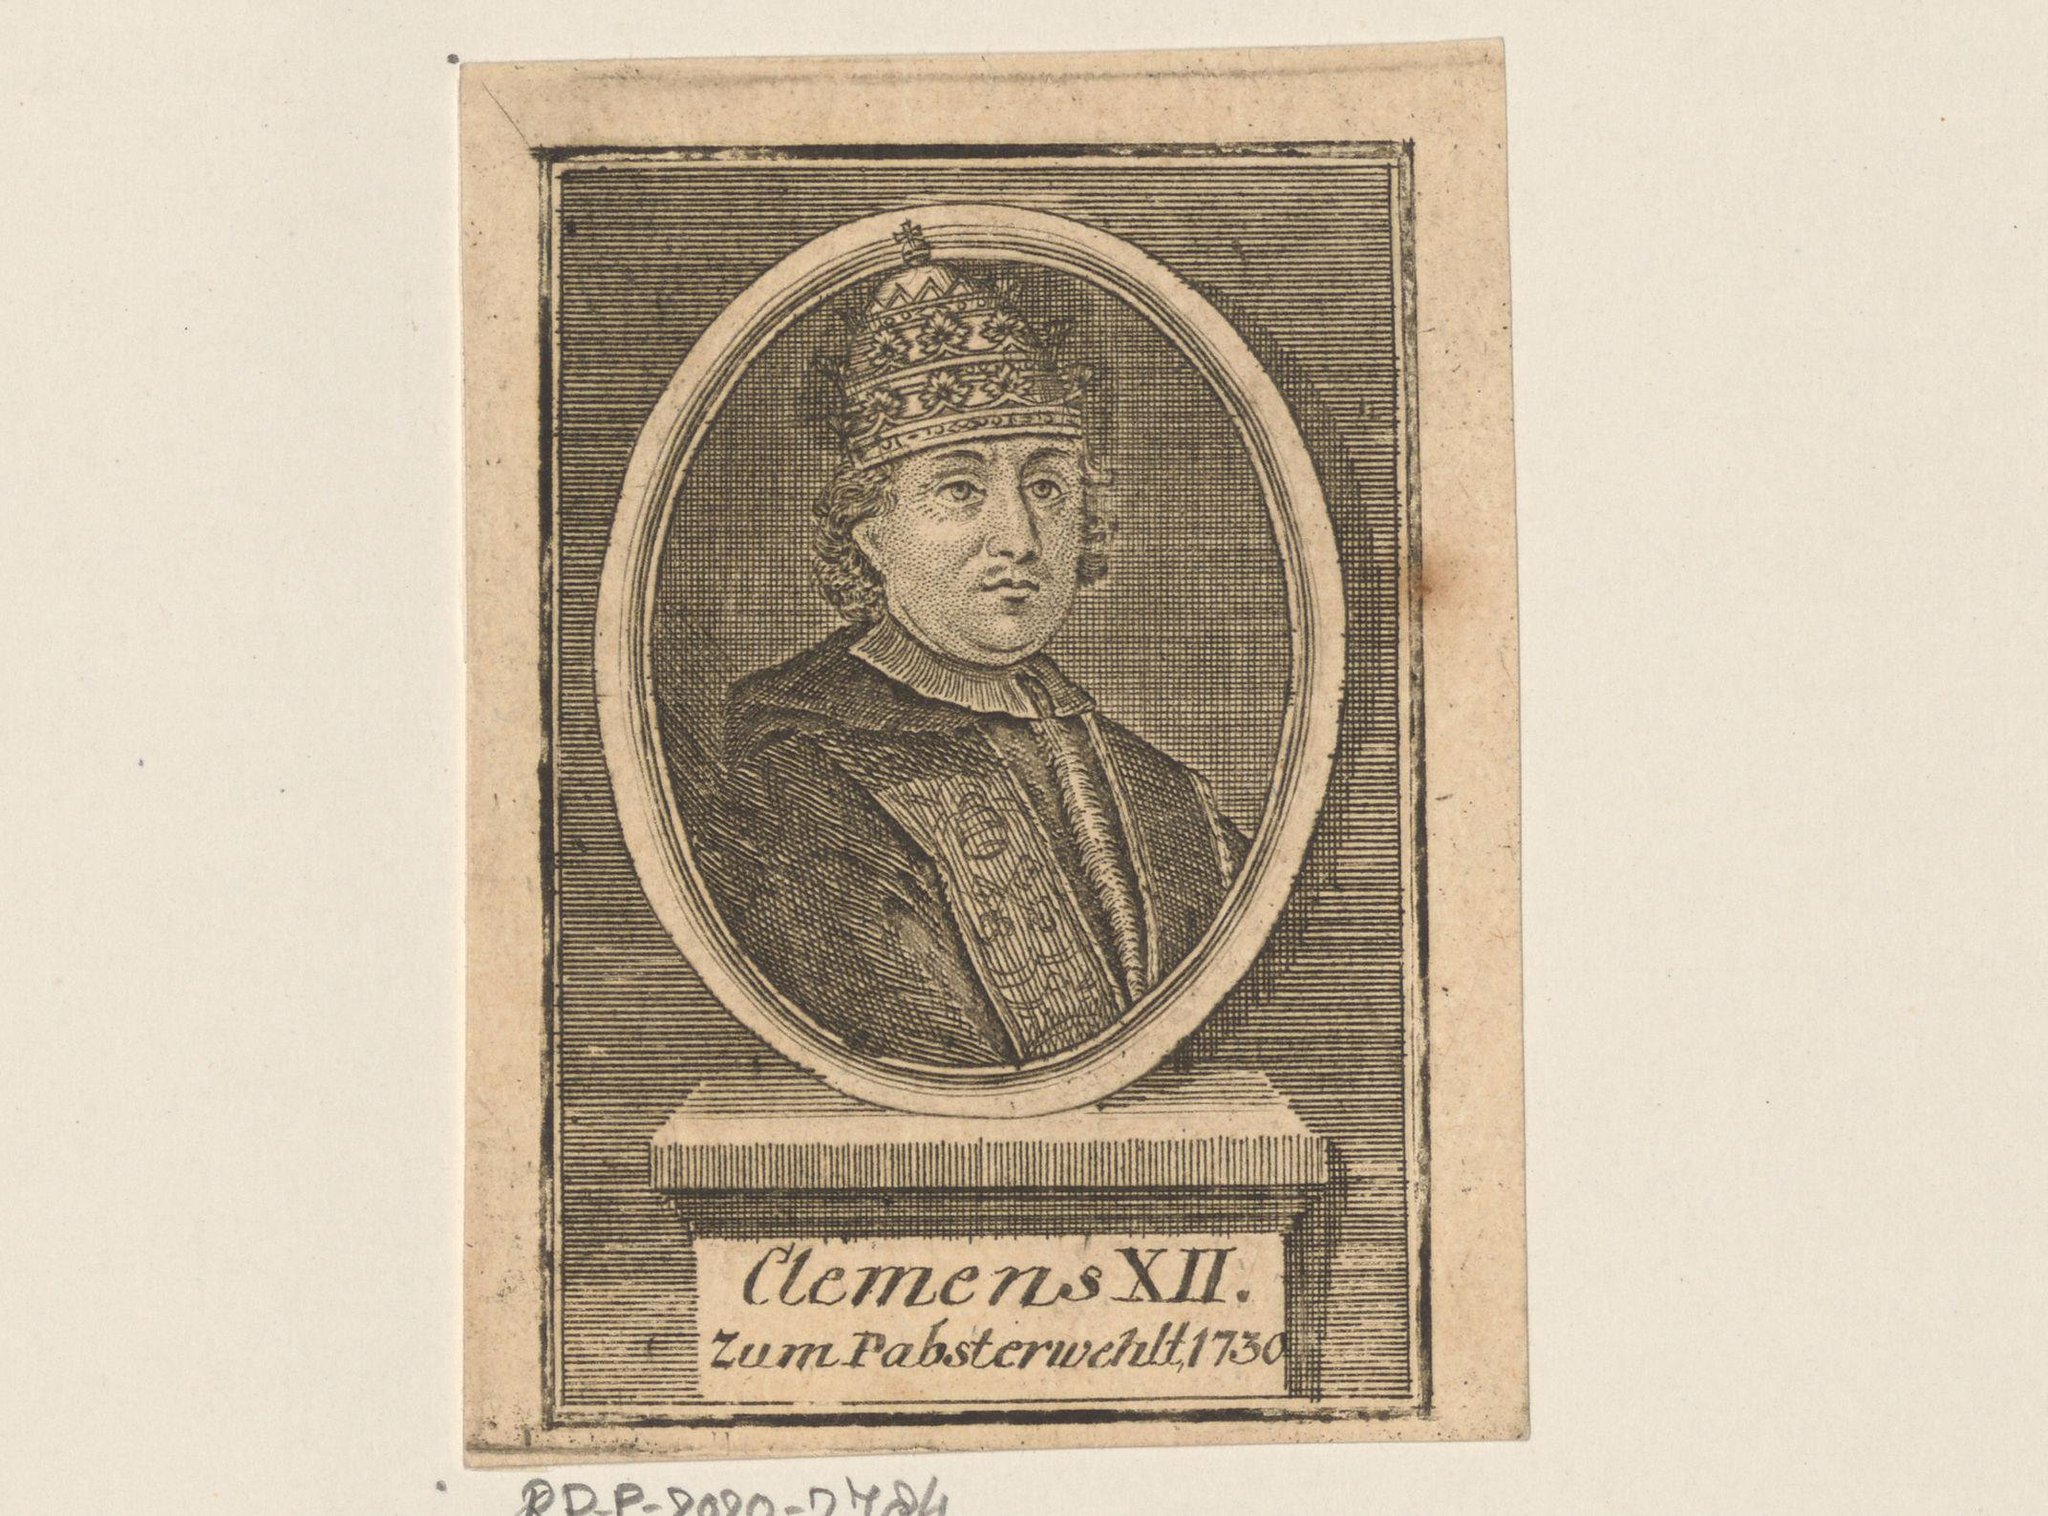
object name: print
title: Portret van paus Clemens XII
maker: Anonymous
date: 1730-1799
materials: paper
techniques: engraving, etching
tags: rome, clemens xii, historical persons, pope